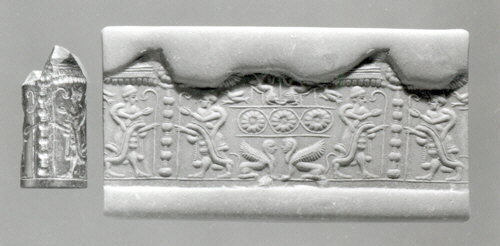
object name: cylinder seal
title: Cylinder seal and modern impression: royal figures flanking a standard; sphinxes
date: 1720-1650 BCE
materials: mineral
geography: levant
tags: sphinx